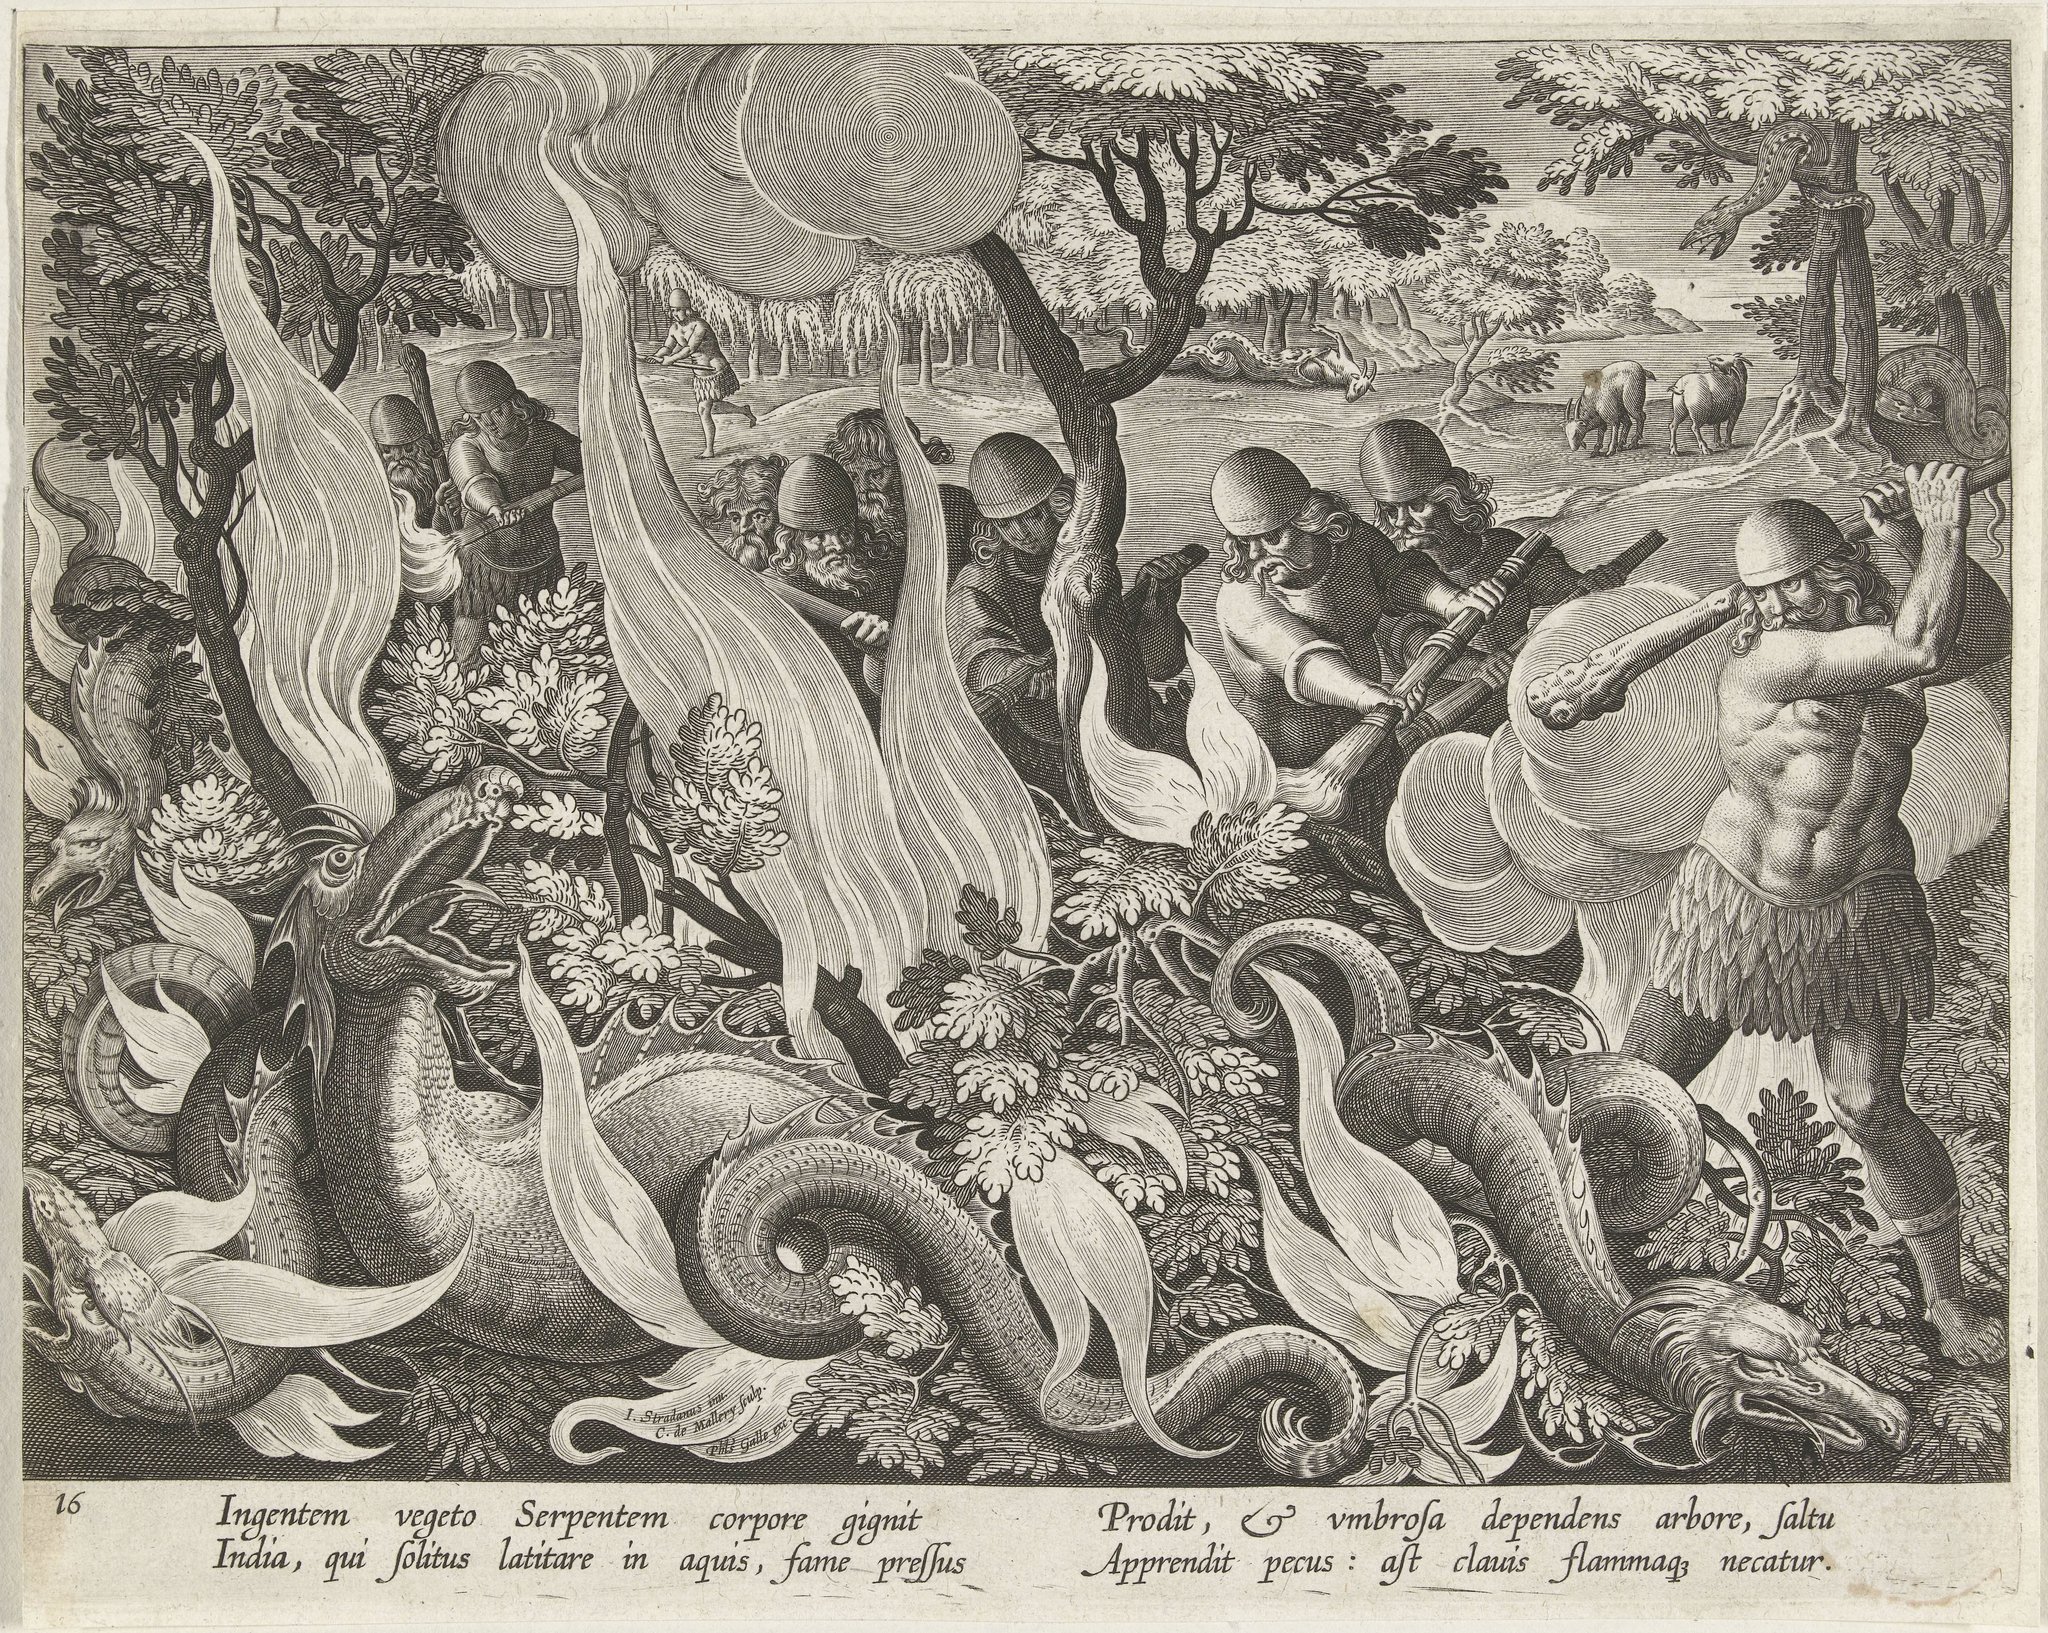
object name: print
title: Venationes Ferarum, auium, piscium pvgnae Bestiariorum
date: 1594-1598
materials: paper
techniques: engraving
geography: antwerp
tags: hunting, chase, dragon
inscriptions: collector's mark: Lugt 240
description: Verscheidene Indiase waterslangen worden uit het struikgewas verjaagd door vuur. Vervolgens worden ze doodgeslagen met een knuppel. De prent heeft een Latijns onderschrift en is deel van een serie over jachttaferelen.